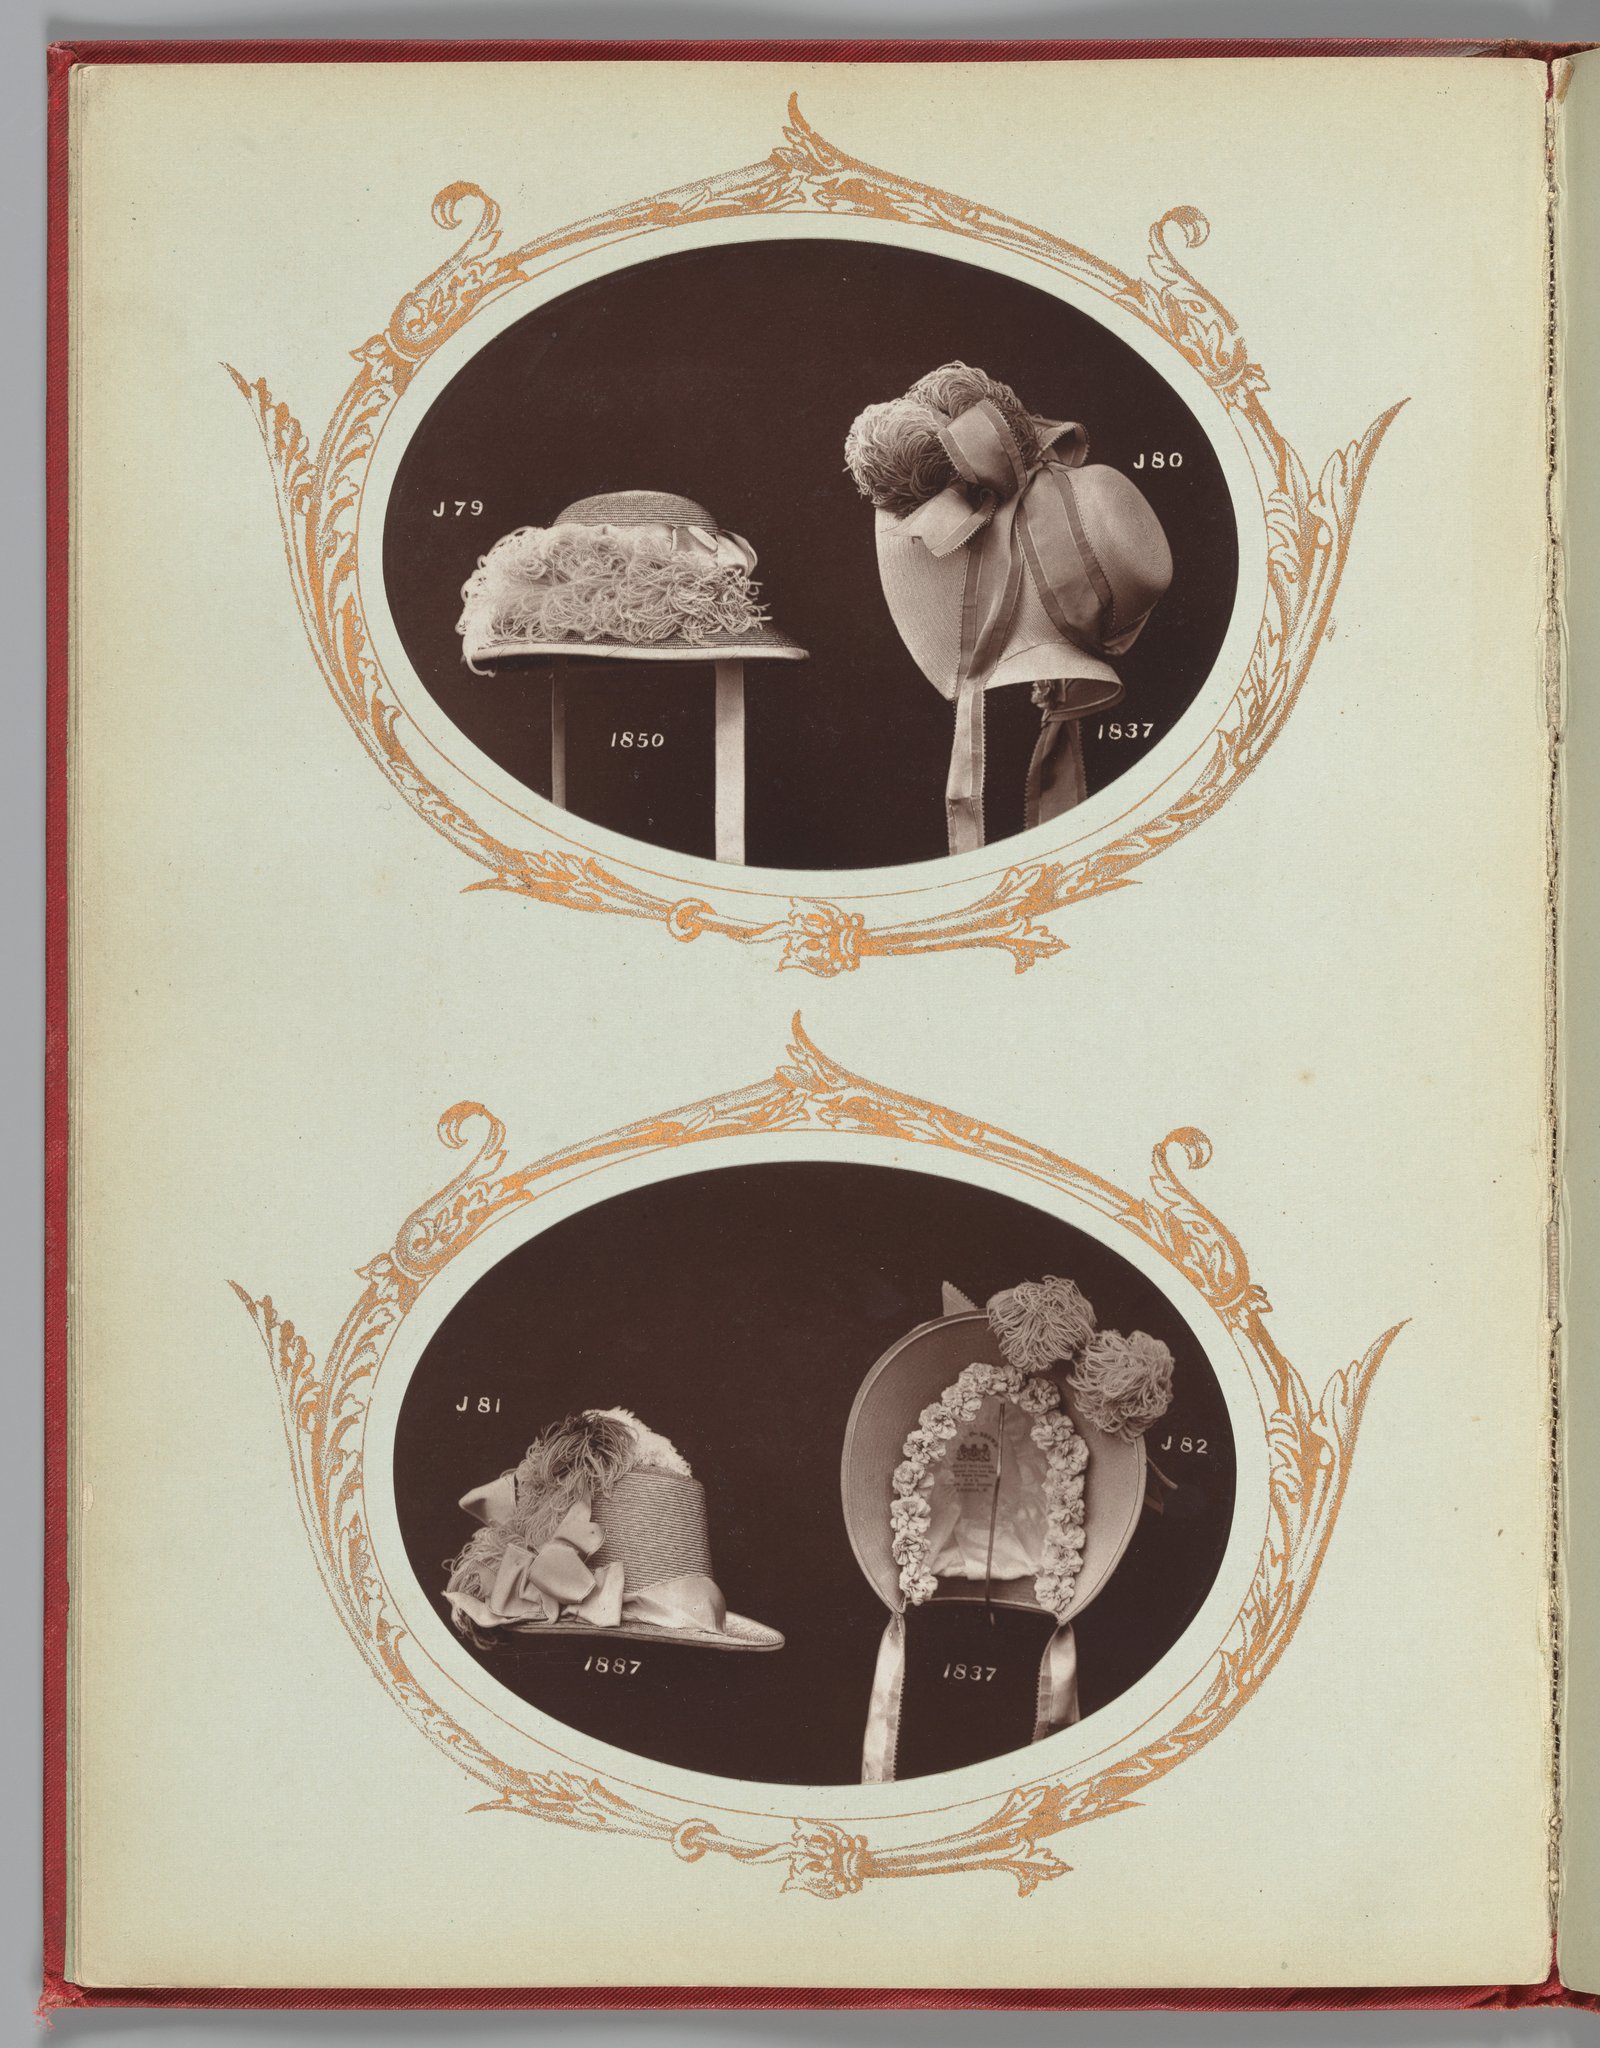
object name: photographically illustrated book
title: [Hats J79-J80]; [Hats J81-J82]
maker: william charles brown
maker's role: author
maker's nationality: british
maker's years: 1800-1899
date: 1888